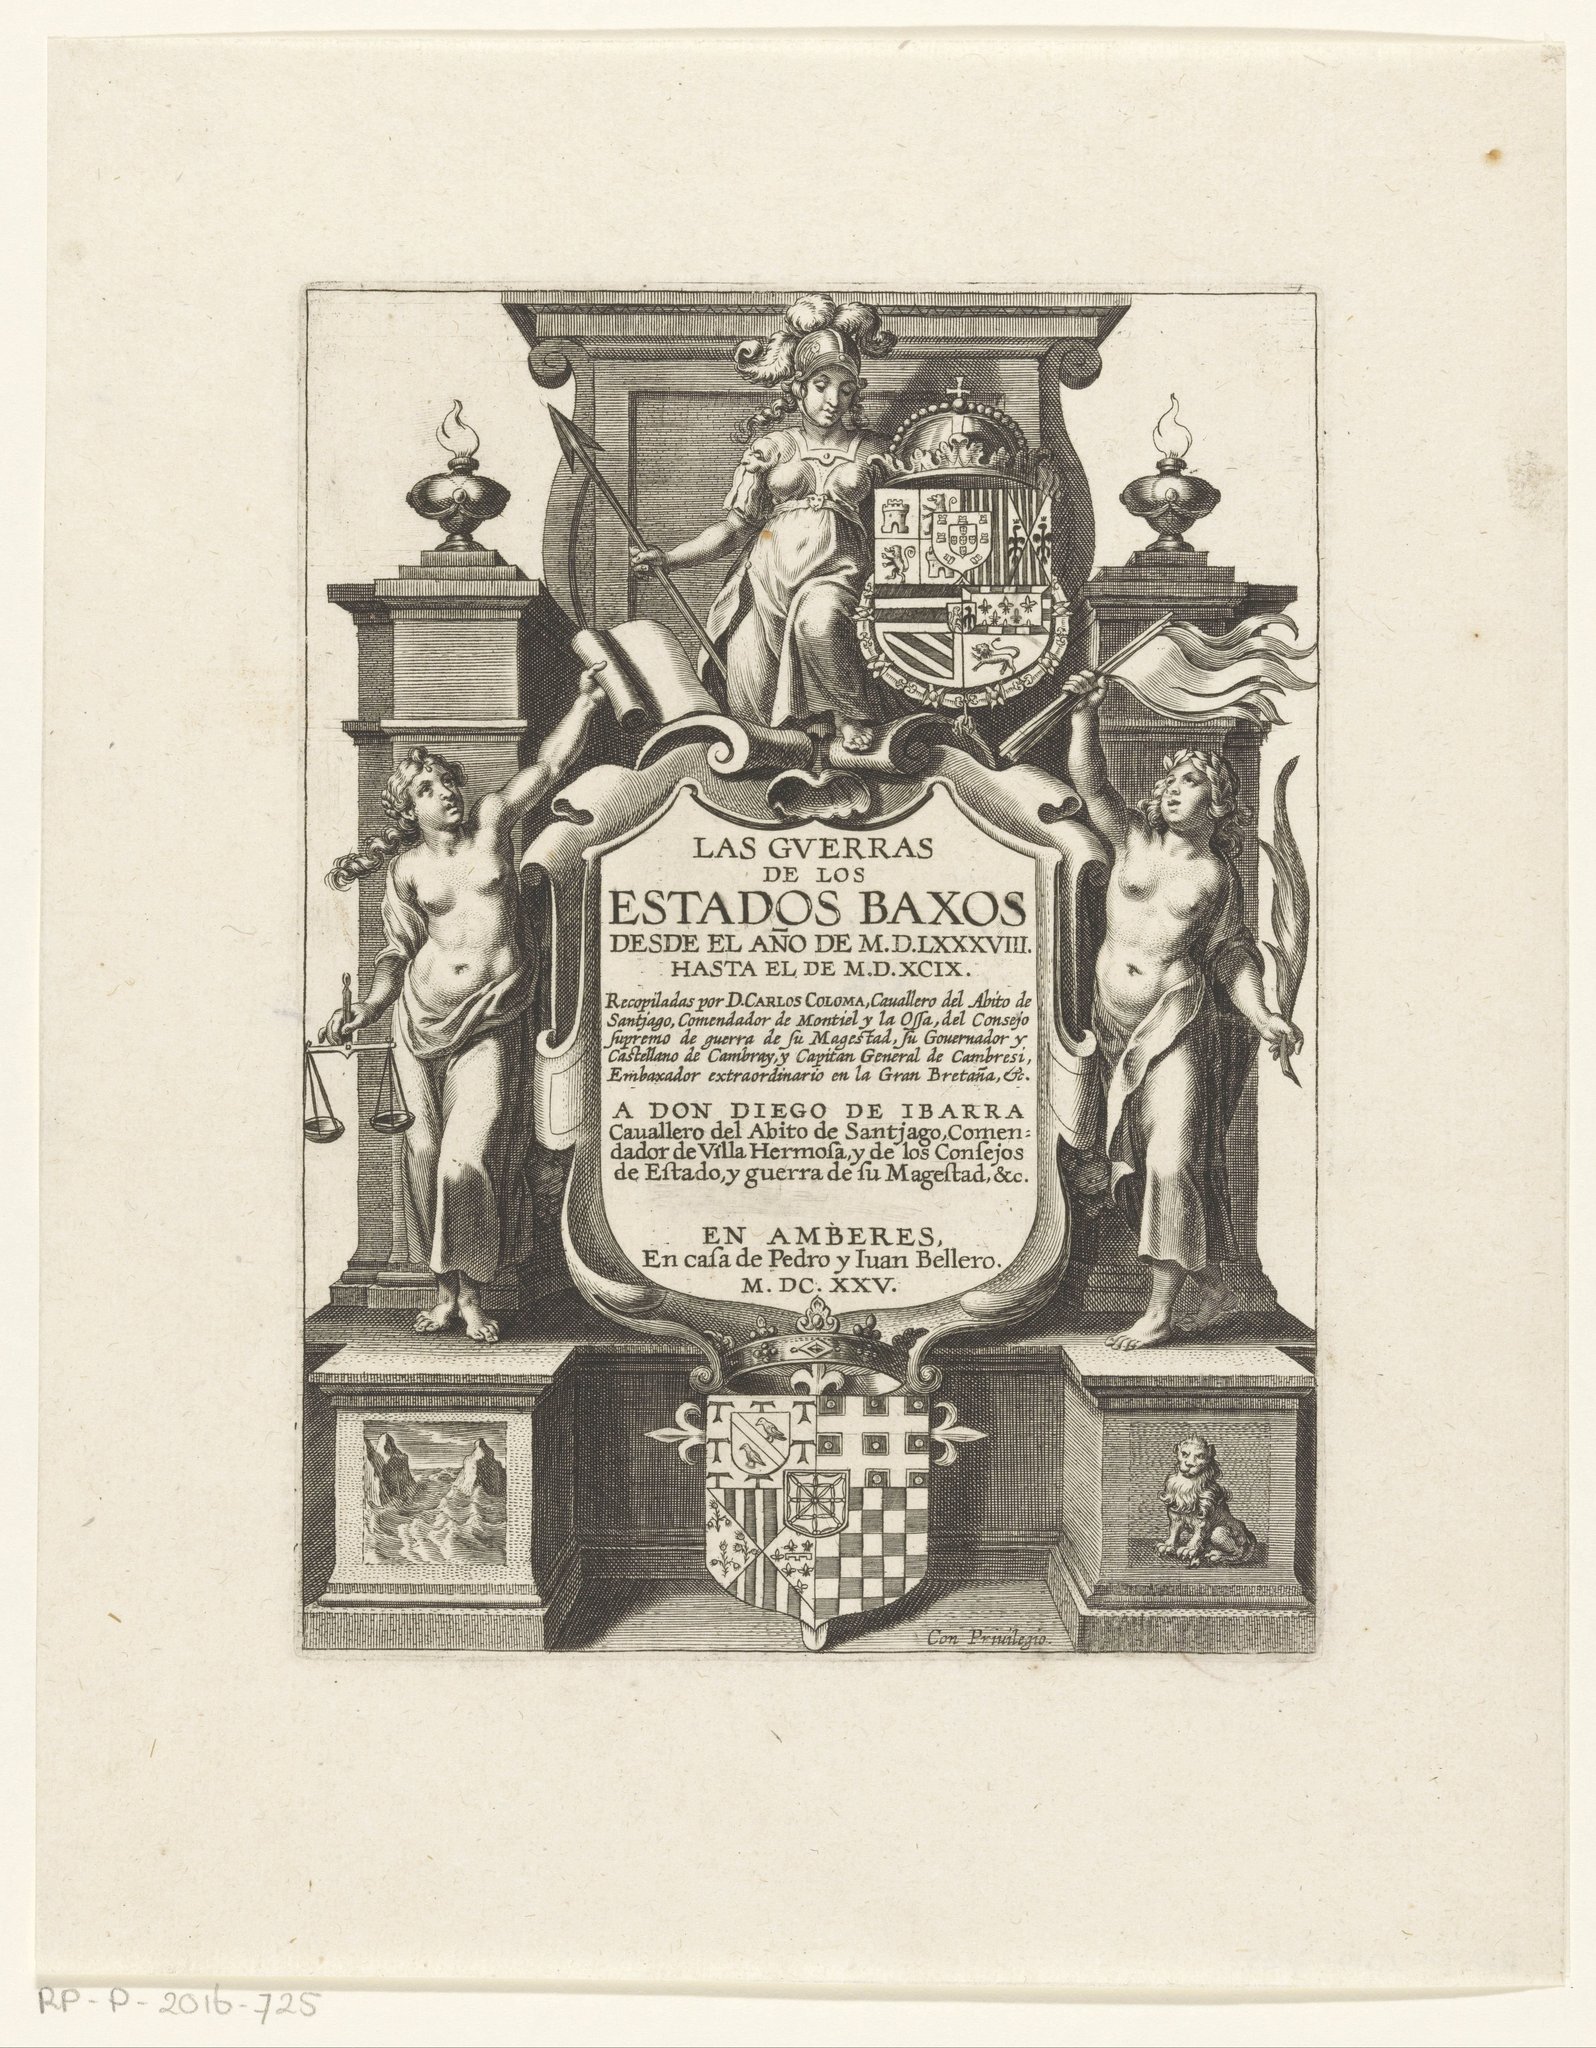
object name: print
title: Titelpagina voor: Carlos Coloma, Las guerras de los estados baxos, 1625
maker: Anonymous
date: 1625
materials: paper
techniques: engraving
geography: antwerp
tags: standing figure - aa - female human figure, armorial bearing, heraldry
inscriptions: collector's mark: Lugt 240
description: Een vrouw in harnas, mogelijk Minerva, zit met het gekroonde wapen van Filips II boven de titel in cartouche. Twee personificaties met weegschaal (mogelijk Rechtvaardigheid) en vlaggen flankeren de cartouche. Aan de onderzijde een gekroond wapenschild.